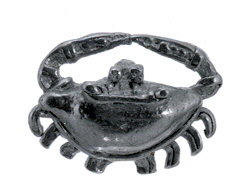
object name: pendant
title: Crab Pendant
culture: costa rican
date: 1001-1600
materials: gold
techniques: casting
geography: costa rica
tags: crabs